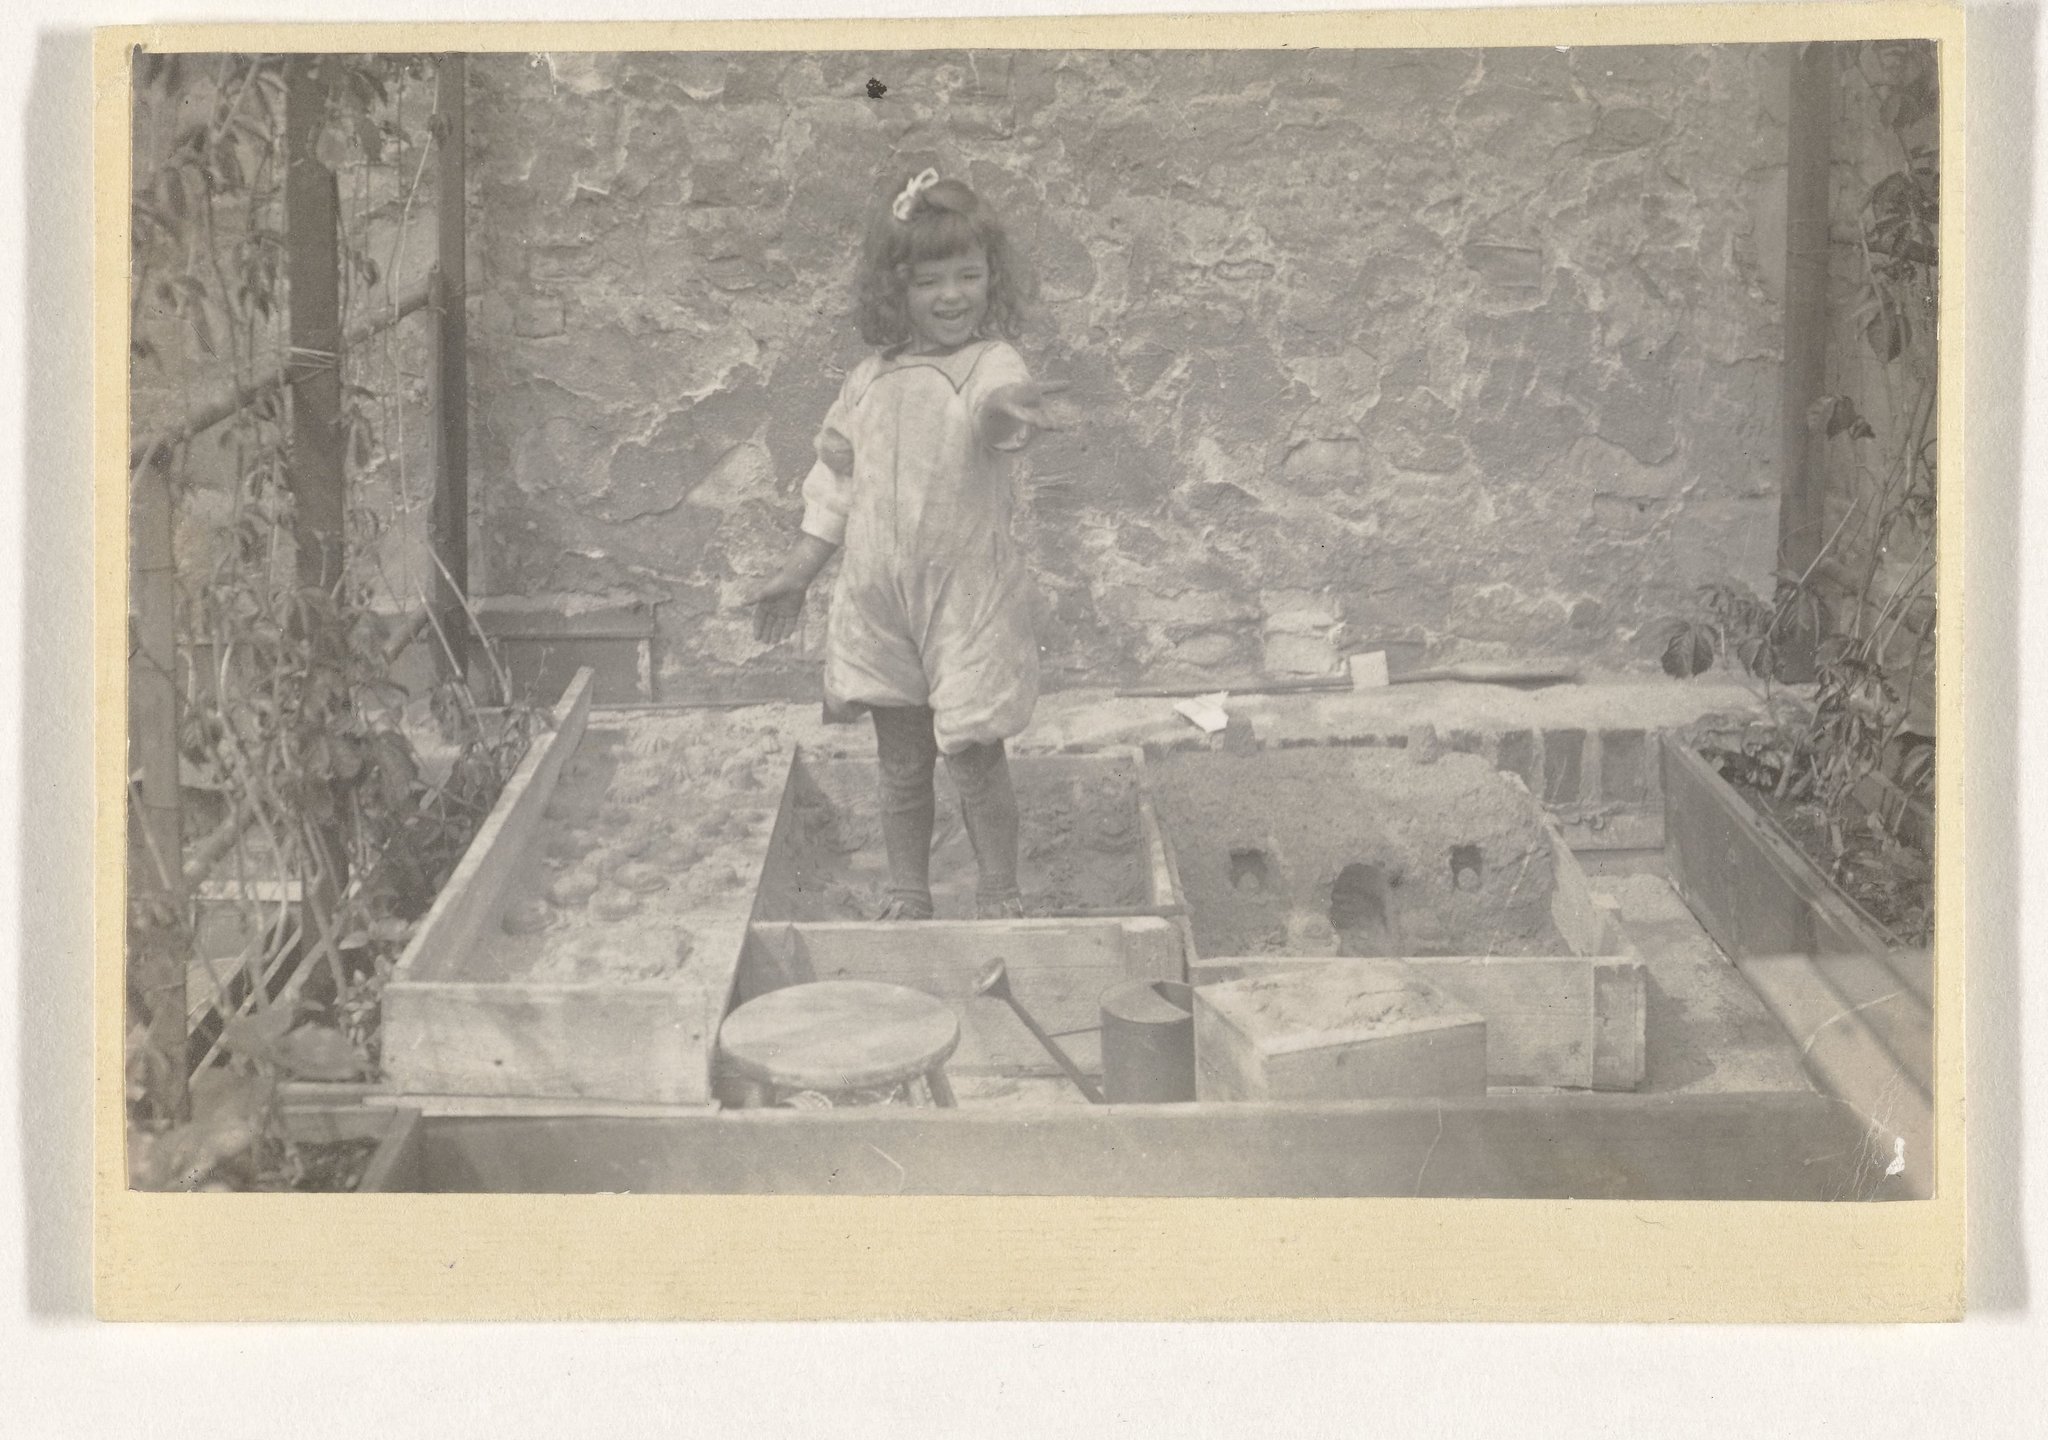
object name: photograph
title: Marba Titzenthaler, dochter van de fotograaf, in zandbak op het dakterras van het woonhuis in de Friedrichstrasse, Berlijn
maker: waldemar titzenthaler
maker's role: fotograaf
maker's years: 1869-1937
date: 1915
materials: paper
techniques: gelatin silver print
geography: berlin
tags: (building) sand-castle, girl (child between toddler and youth), berlin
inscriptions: date: ‘5.6.15’